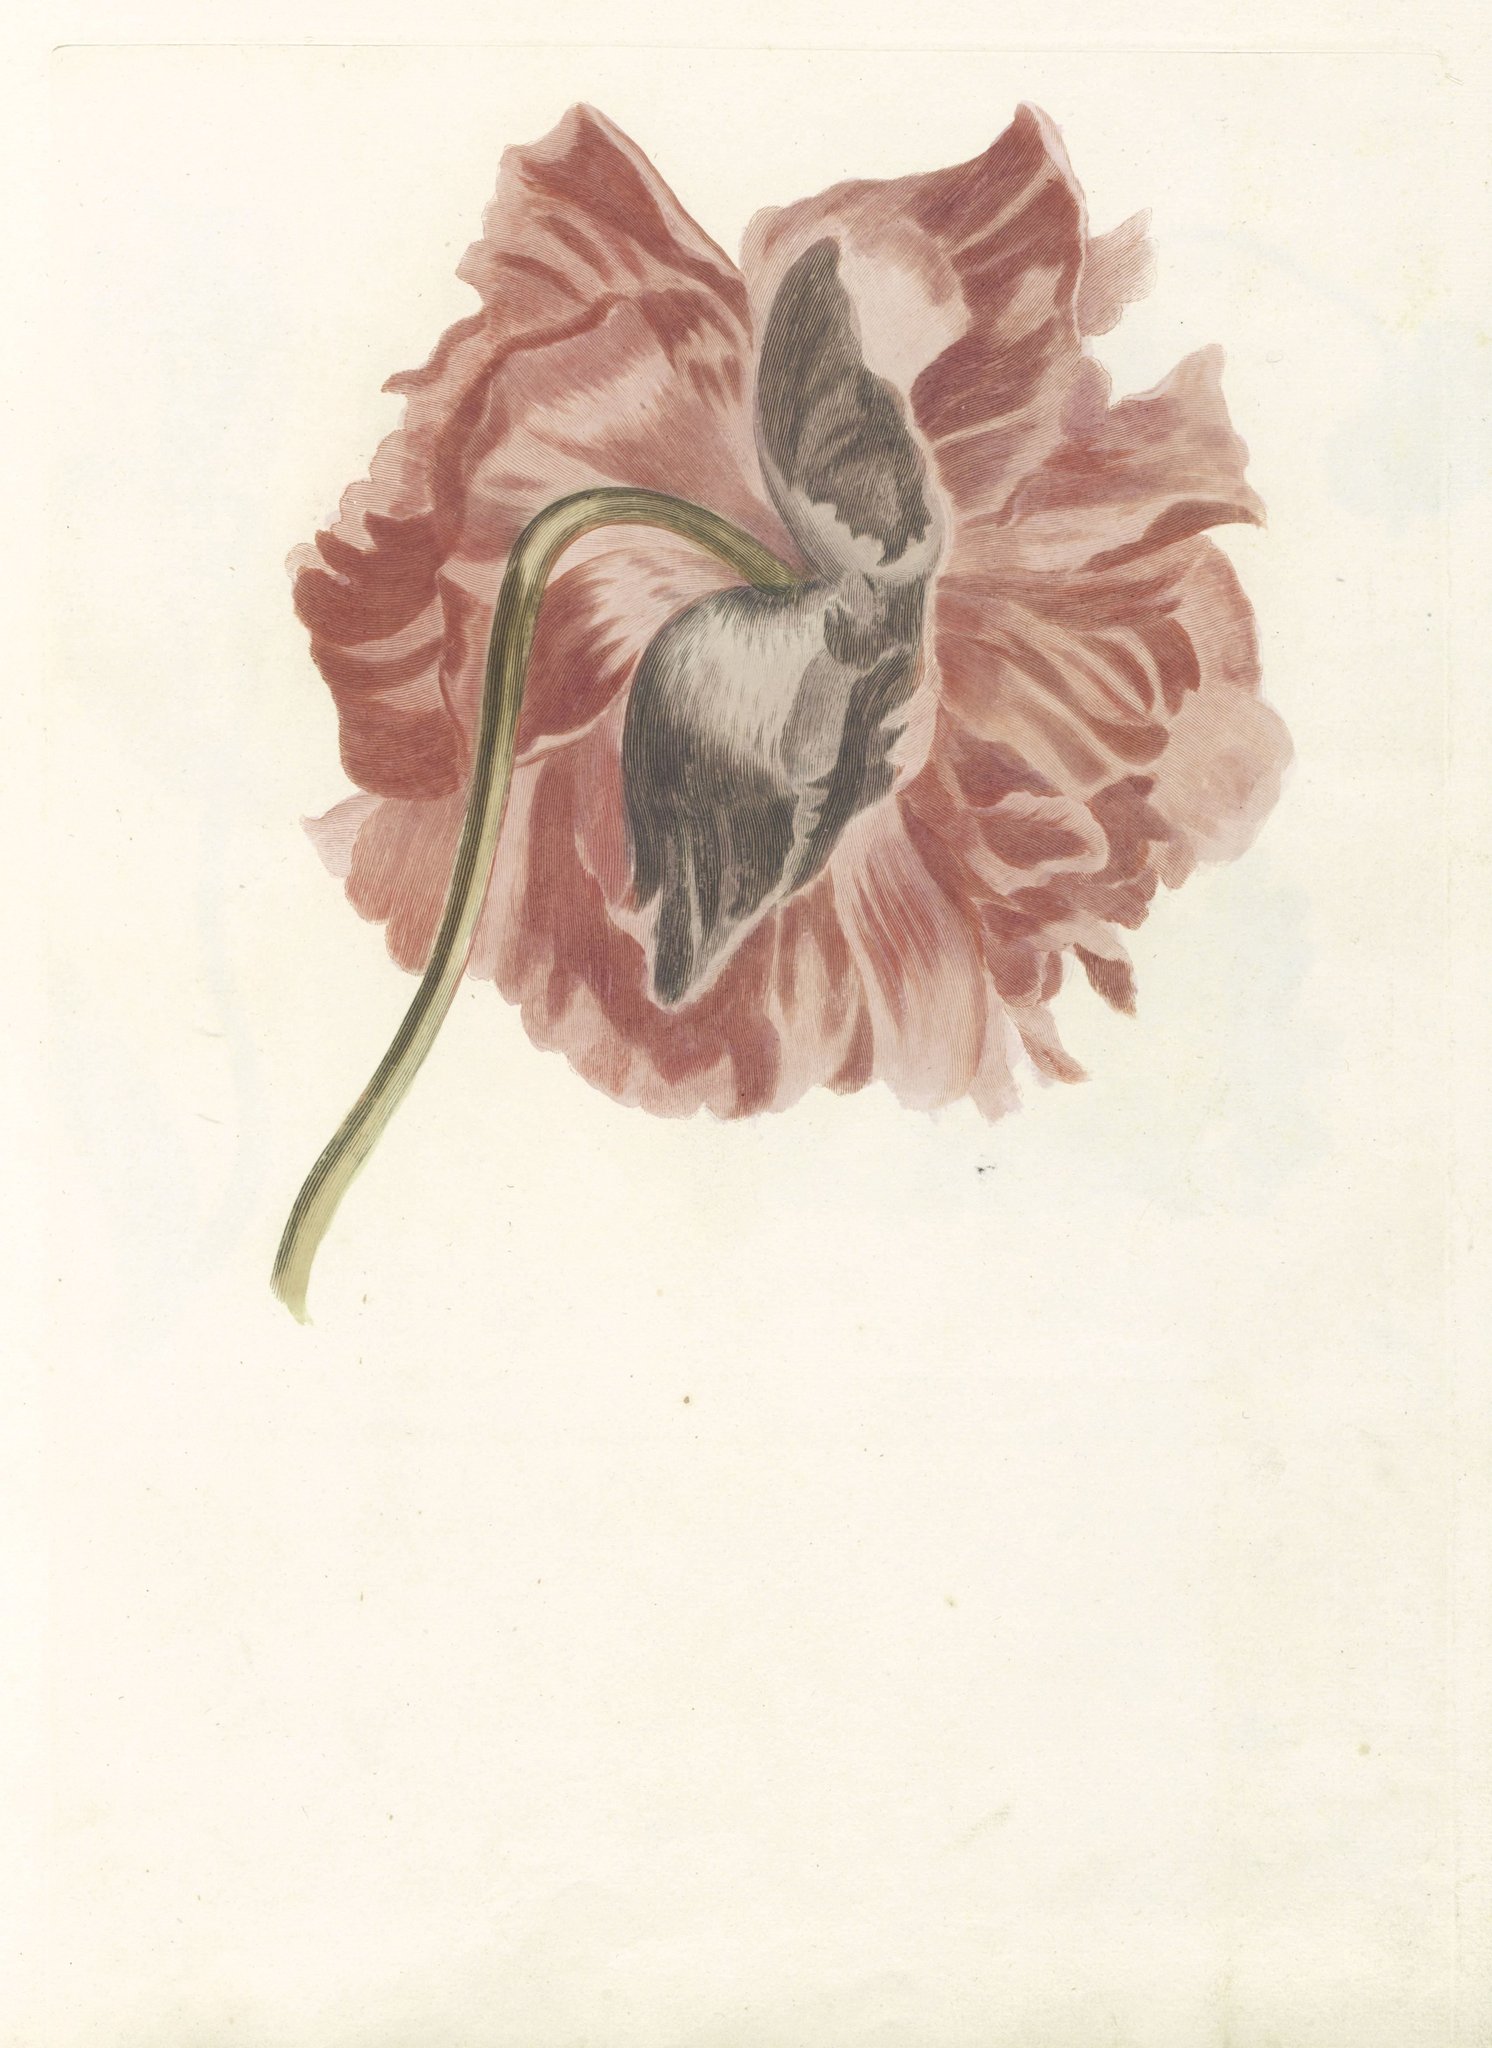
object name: album leaf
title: Pioenroos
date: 1688-1698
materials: paper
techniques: printing, engraving, hand coloring, lithography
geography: netherlands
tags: plants and herbs: peony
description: Deze prent maakt deel uit van een album.